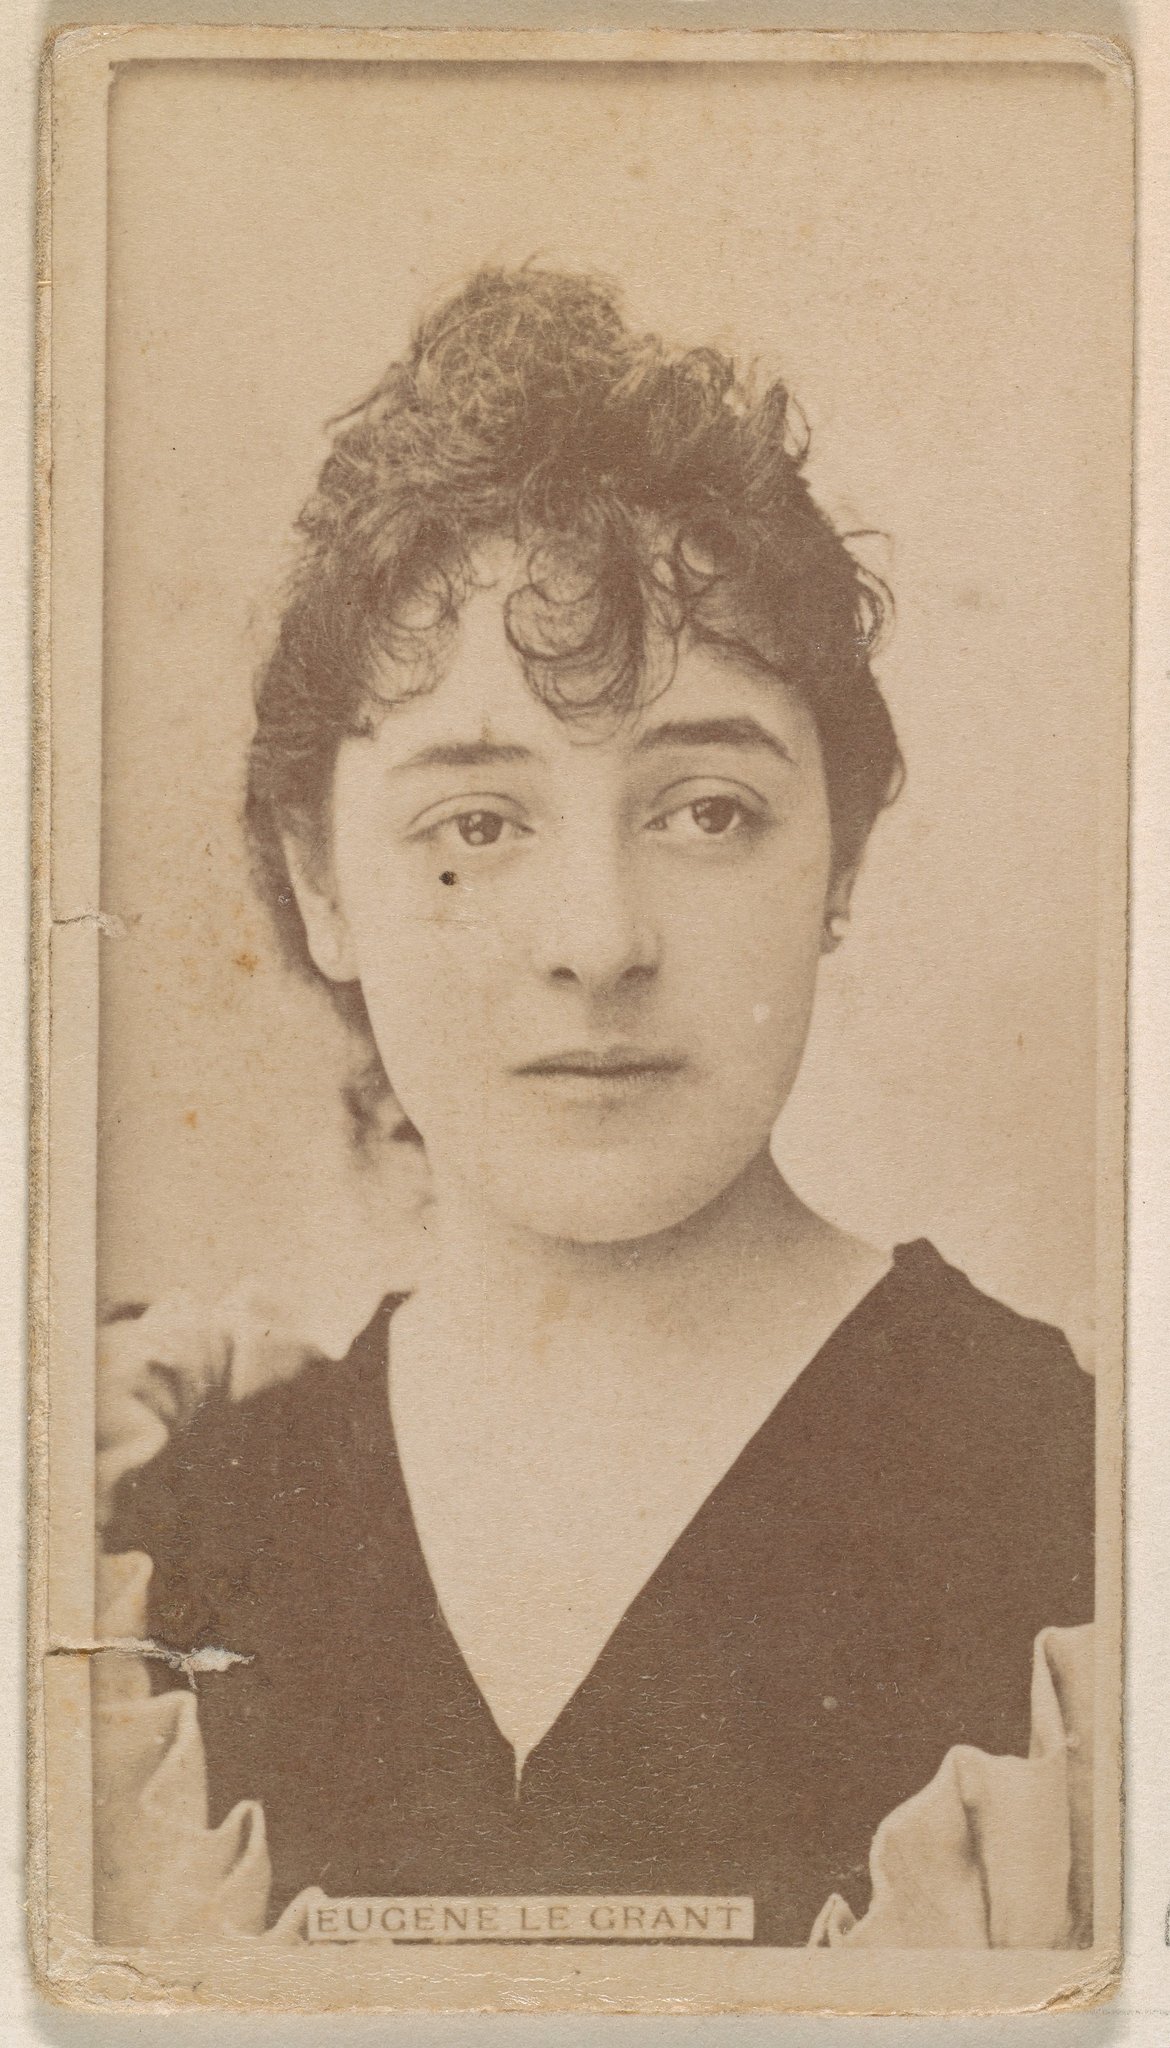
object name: photograph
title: Eugene le Grant, from the Actresses series (N245) issued by Kinney Brothers to promote Sweet Caporal Cigarettes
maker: kinney brothers tobacco company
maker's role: publisher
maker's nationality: american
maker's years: 1869-2011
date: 1890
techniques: albumen silver print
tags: portraits,women,actresses